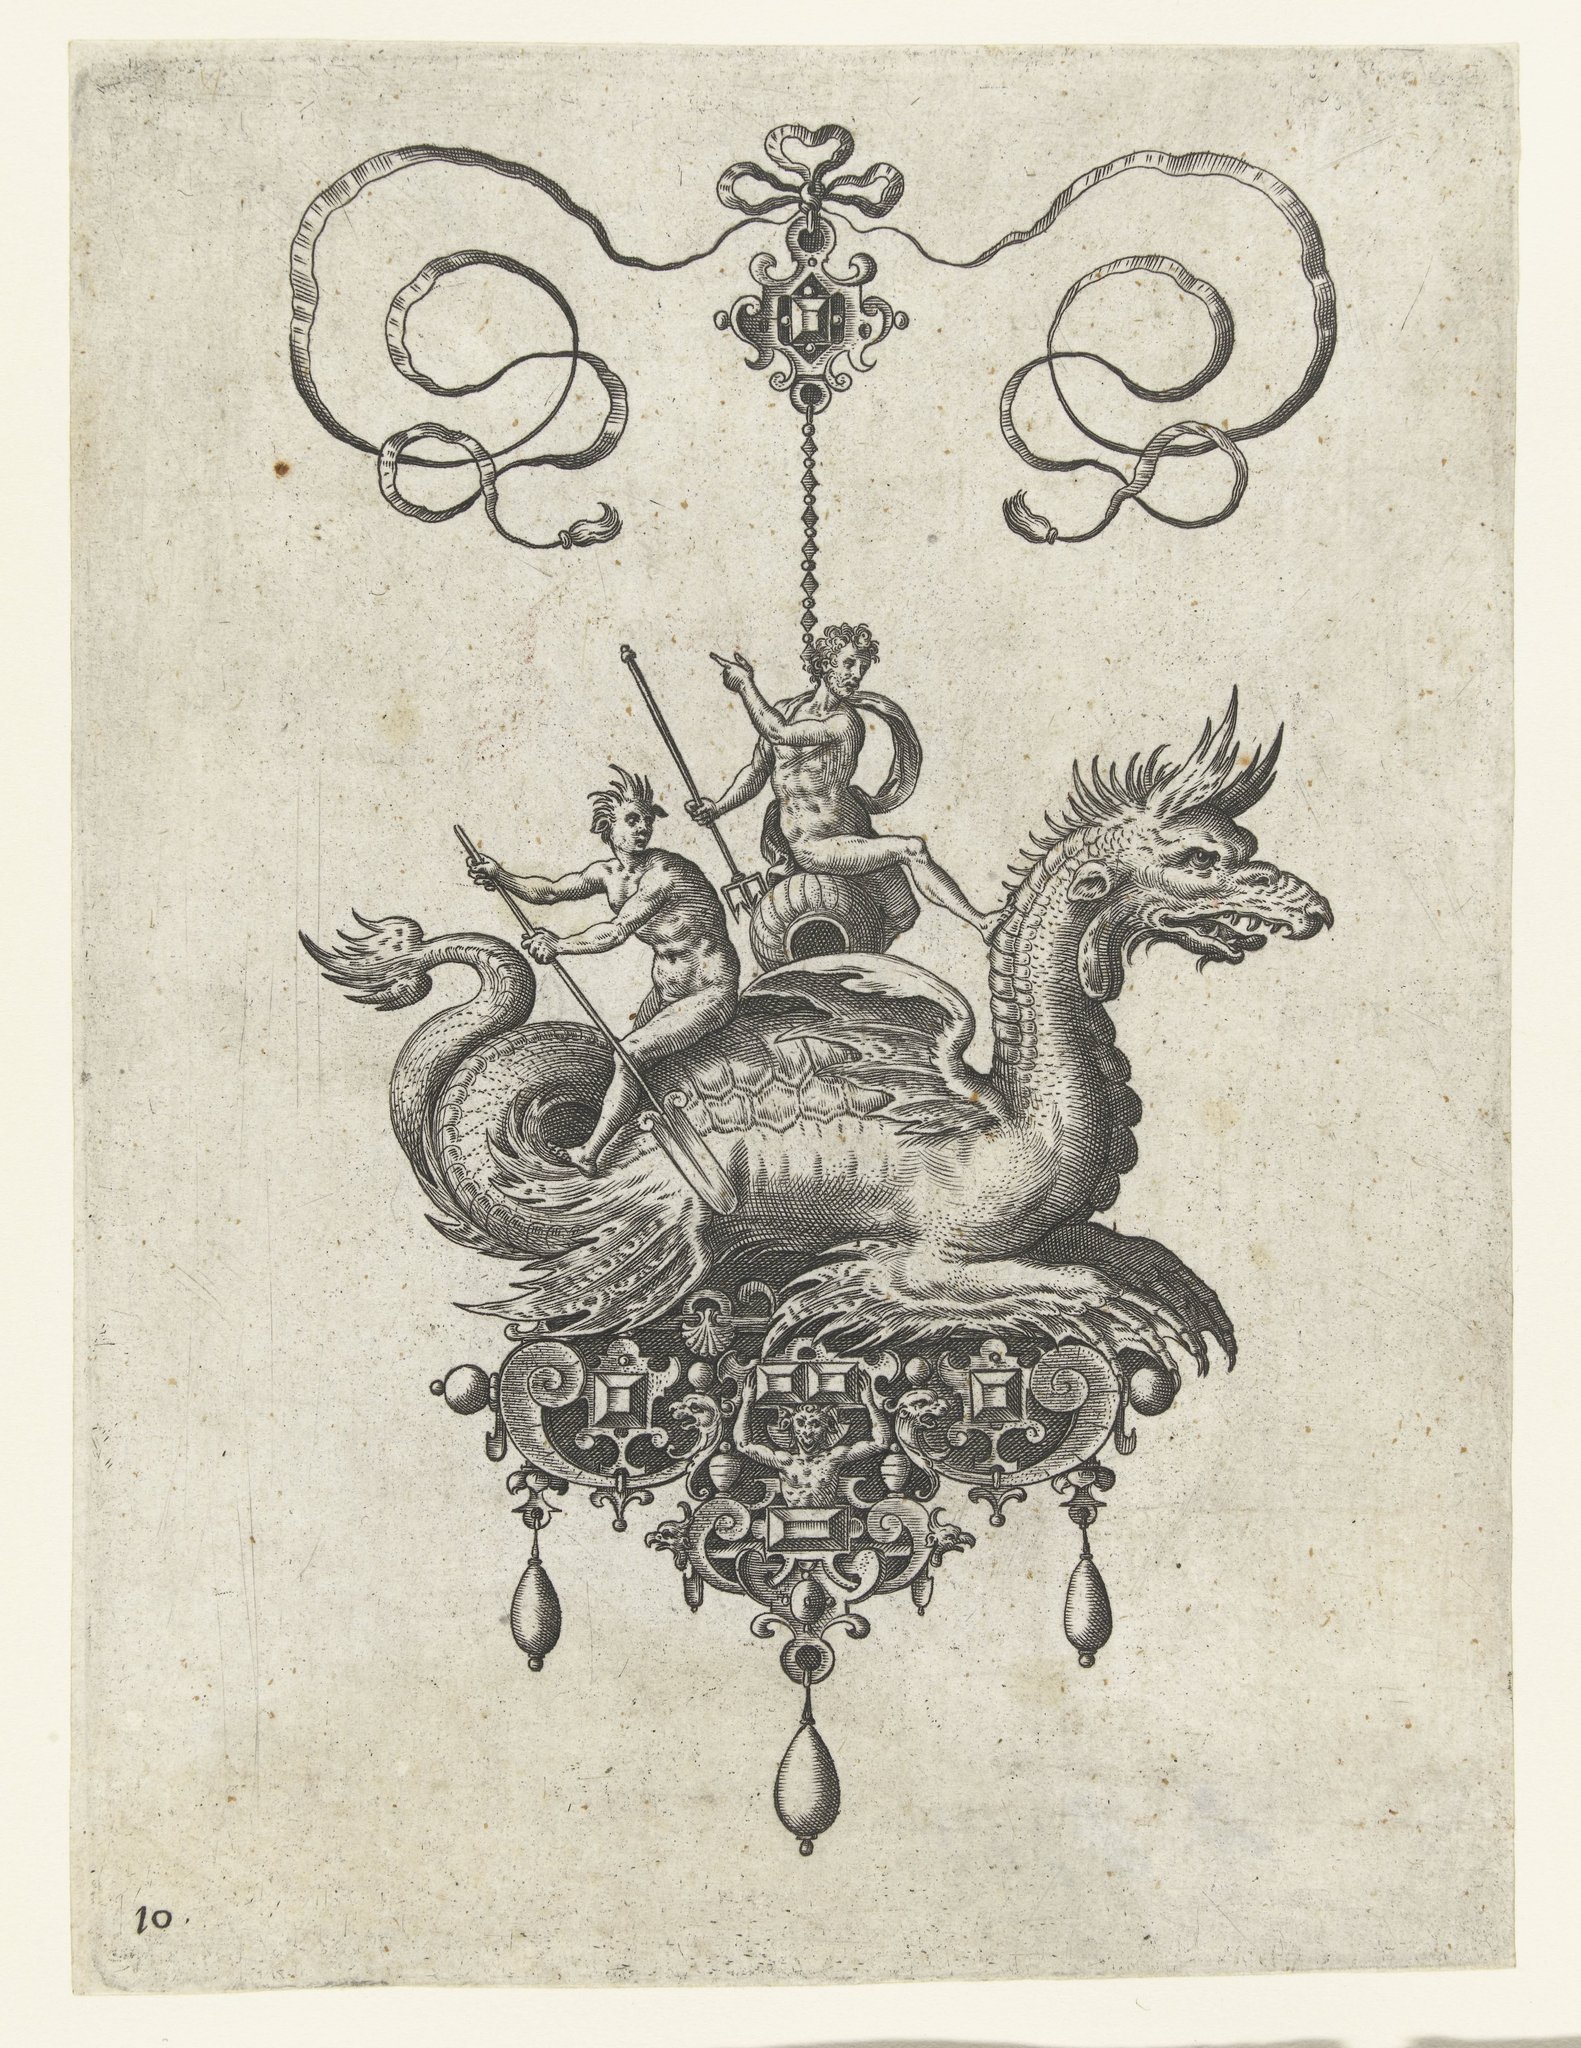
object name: ornament print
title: Bullarum inaurium (...)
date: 1582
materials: paper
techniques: engraving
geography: netherlands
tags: 'pistrix', sea-dragon, pendant, trinket, 'breloque'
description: Op de rug van de zeedraak zitten een man met een drietand en een man met een roeispaan. Een van 7 deels genummerde bladen afkomstig uit een serie van 10 bladen met hangers. Aan elke hanger hangen drie parels.